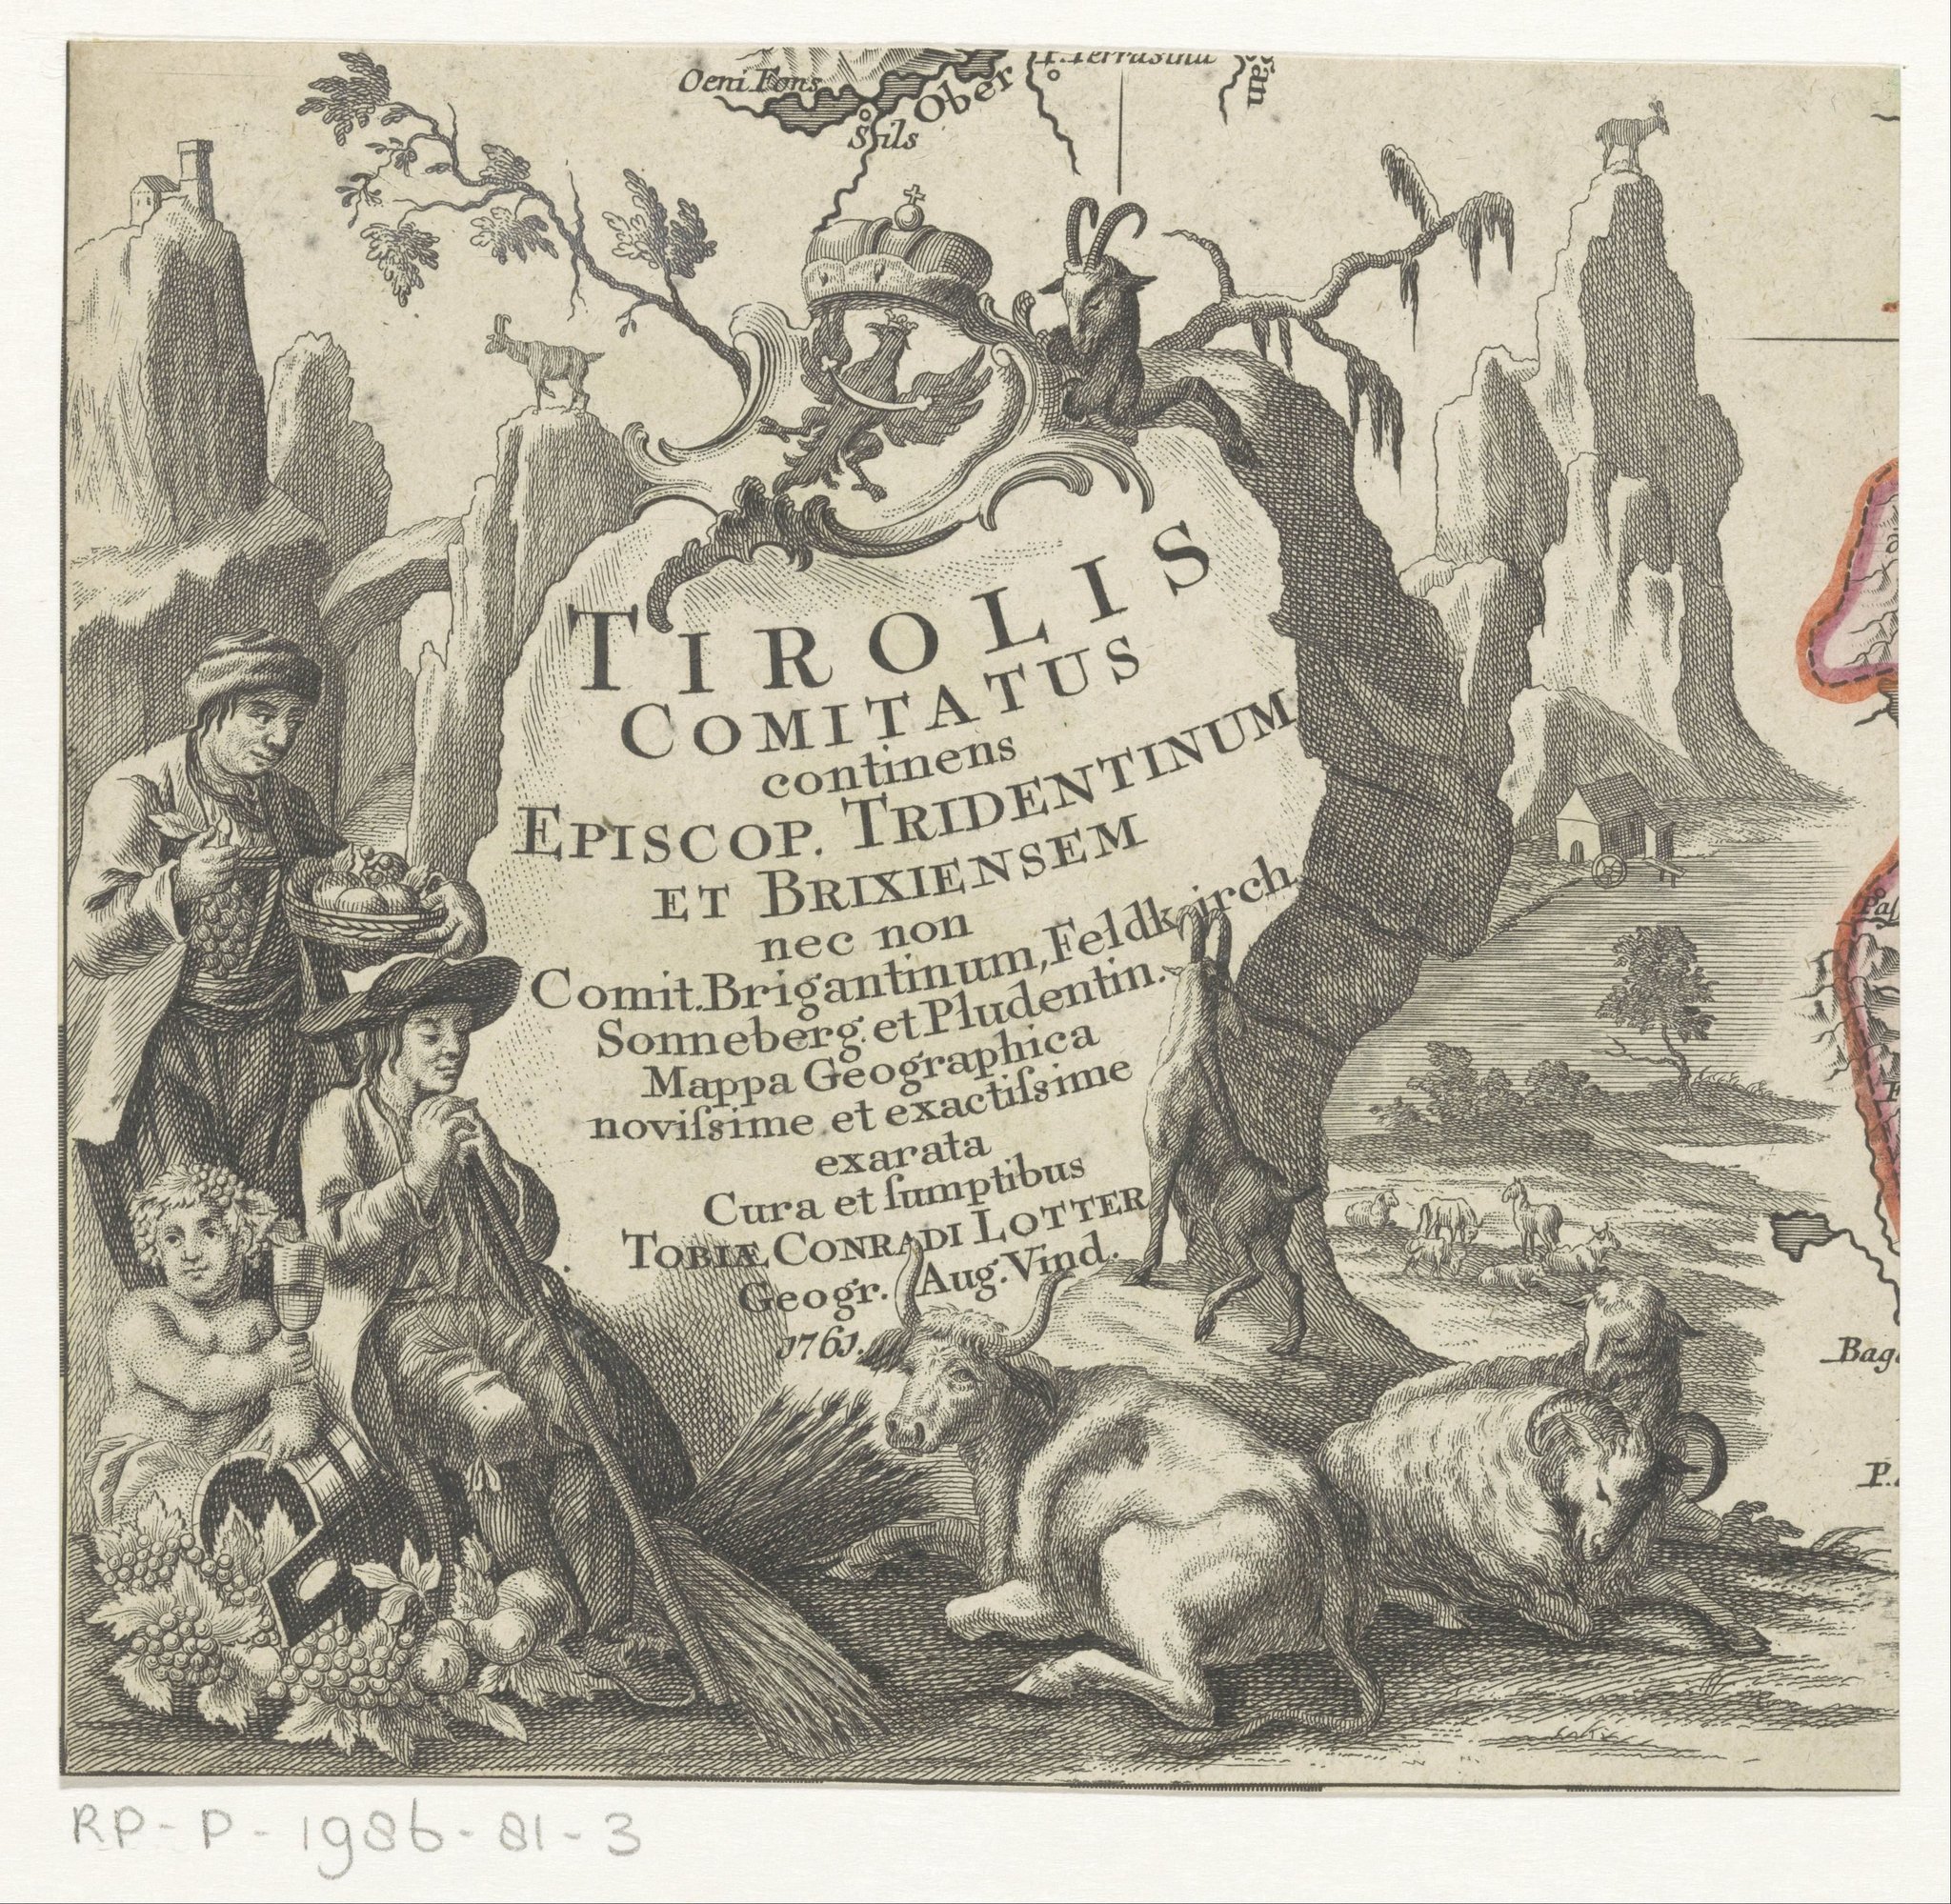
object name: print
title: Tirolis Comitatus continens Episcop. Tridentinum et Brixiensem (...)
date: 1761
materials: paper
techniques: engraving, etching, hand coloring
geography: augsburg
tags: (story of) bacchus (dionysus), liber, herding, herdsman, herdswoman, shepherd, shepherdess, cowherd, etc.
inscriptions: collector's mark: Lugt 2228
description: Een herder met zijn vee, een man met een fruitschaal en Bacchus met een ton en druiventrossen bevinden zich links naast een steen met wapenschild en titel. In de achtergrond een berglandschap met dieren. Detail van een kaart van de regio Tirol in Oostenrijk.